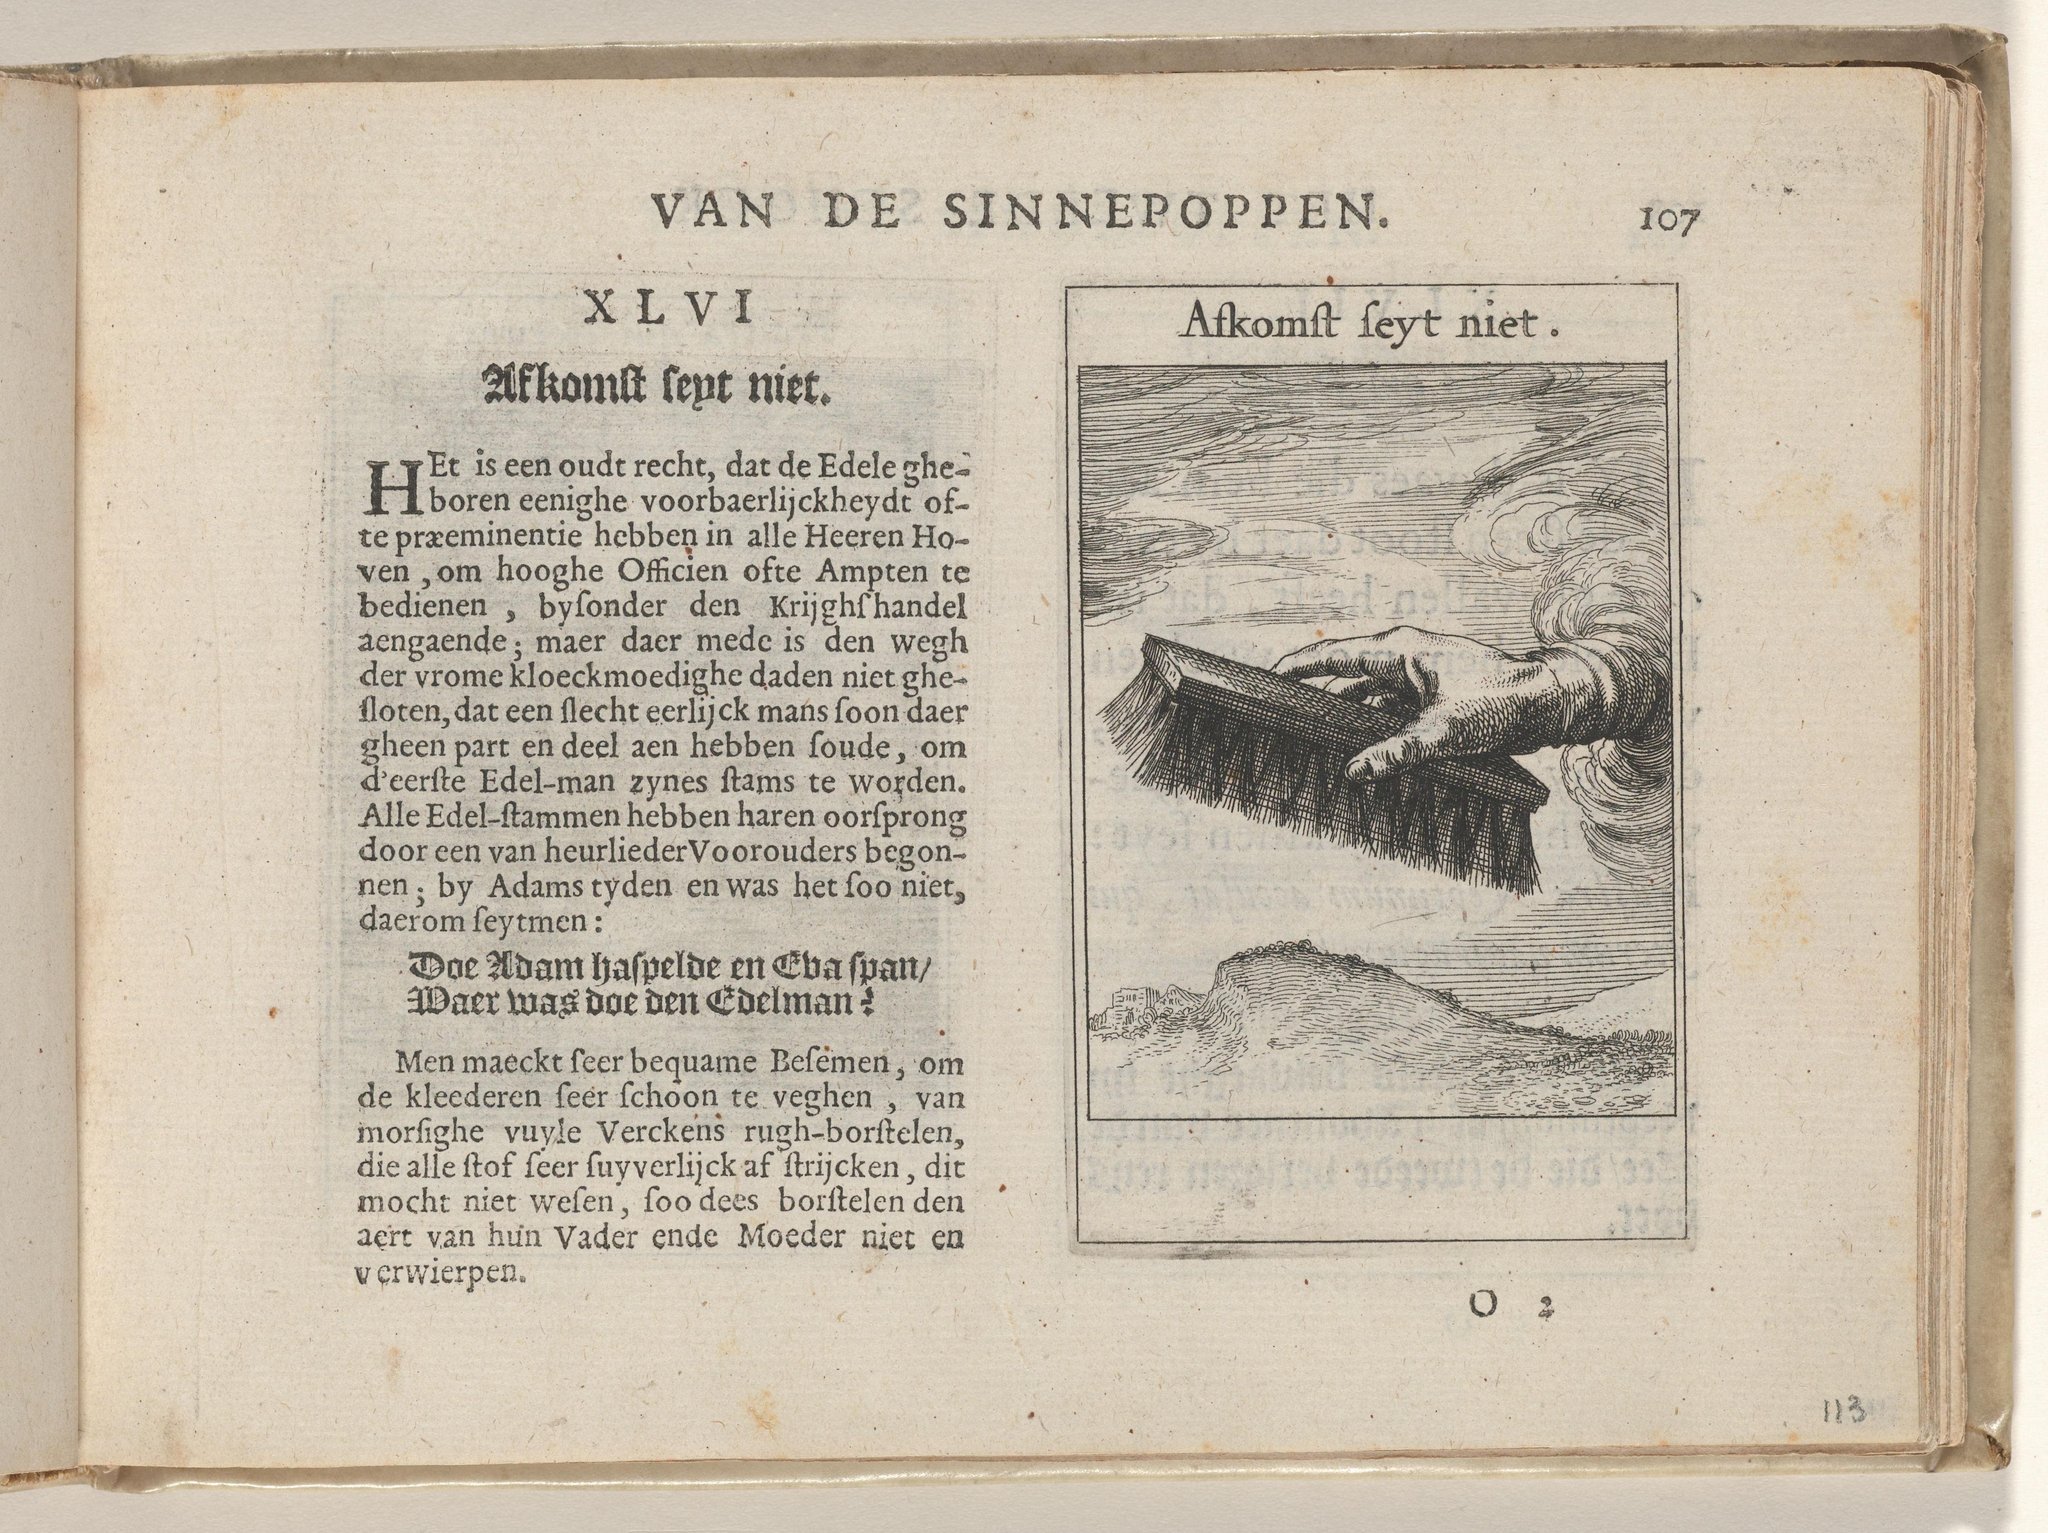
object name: print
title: XLVI Afkomst seyt niet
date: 1614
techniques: engraving, printing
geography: amsterdam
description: XLVI Afkomst seyt niet. Tweede schok. Onderdeel van 'Sinnepoppen', R. Visscher, 1614.